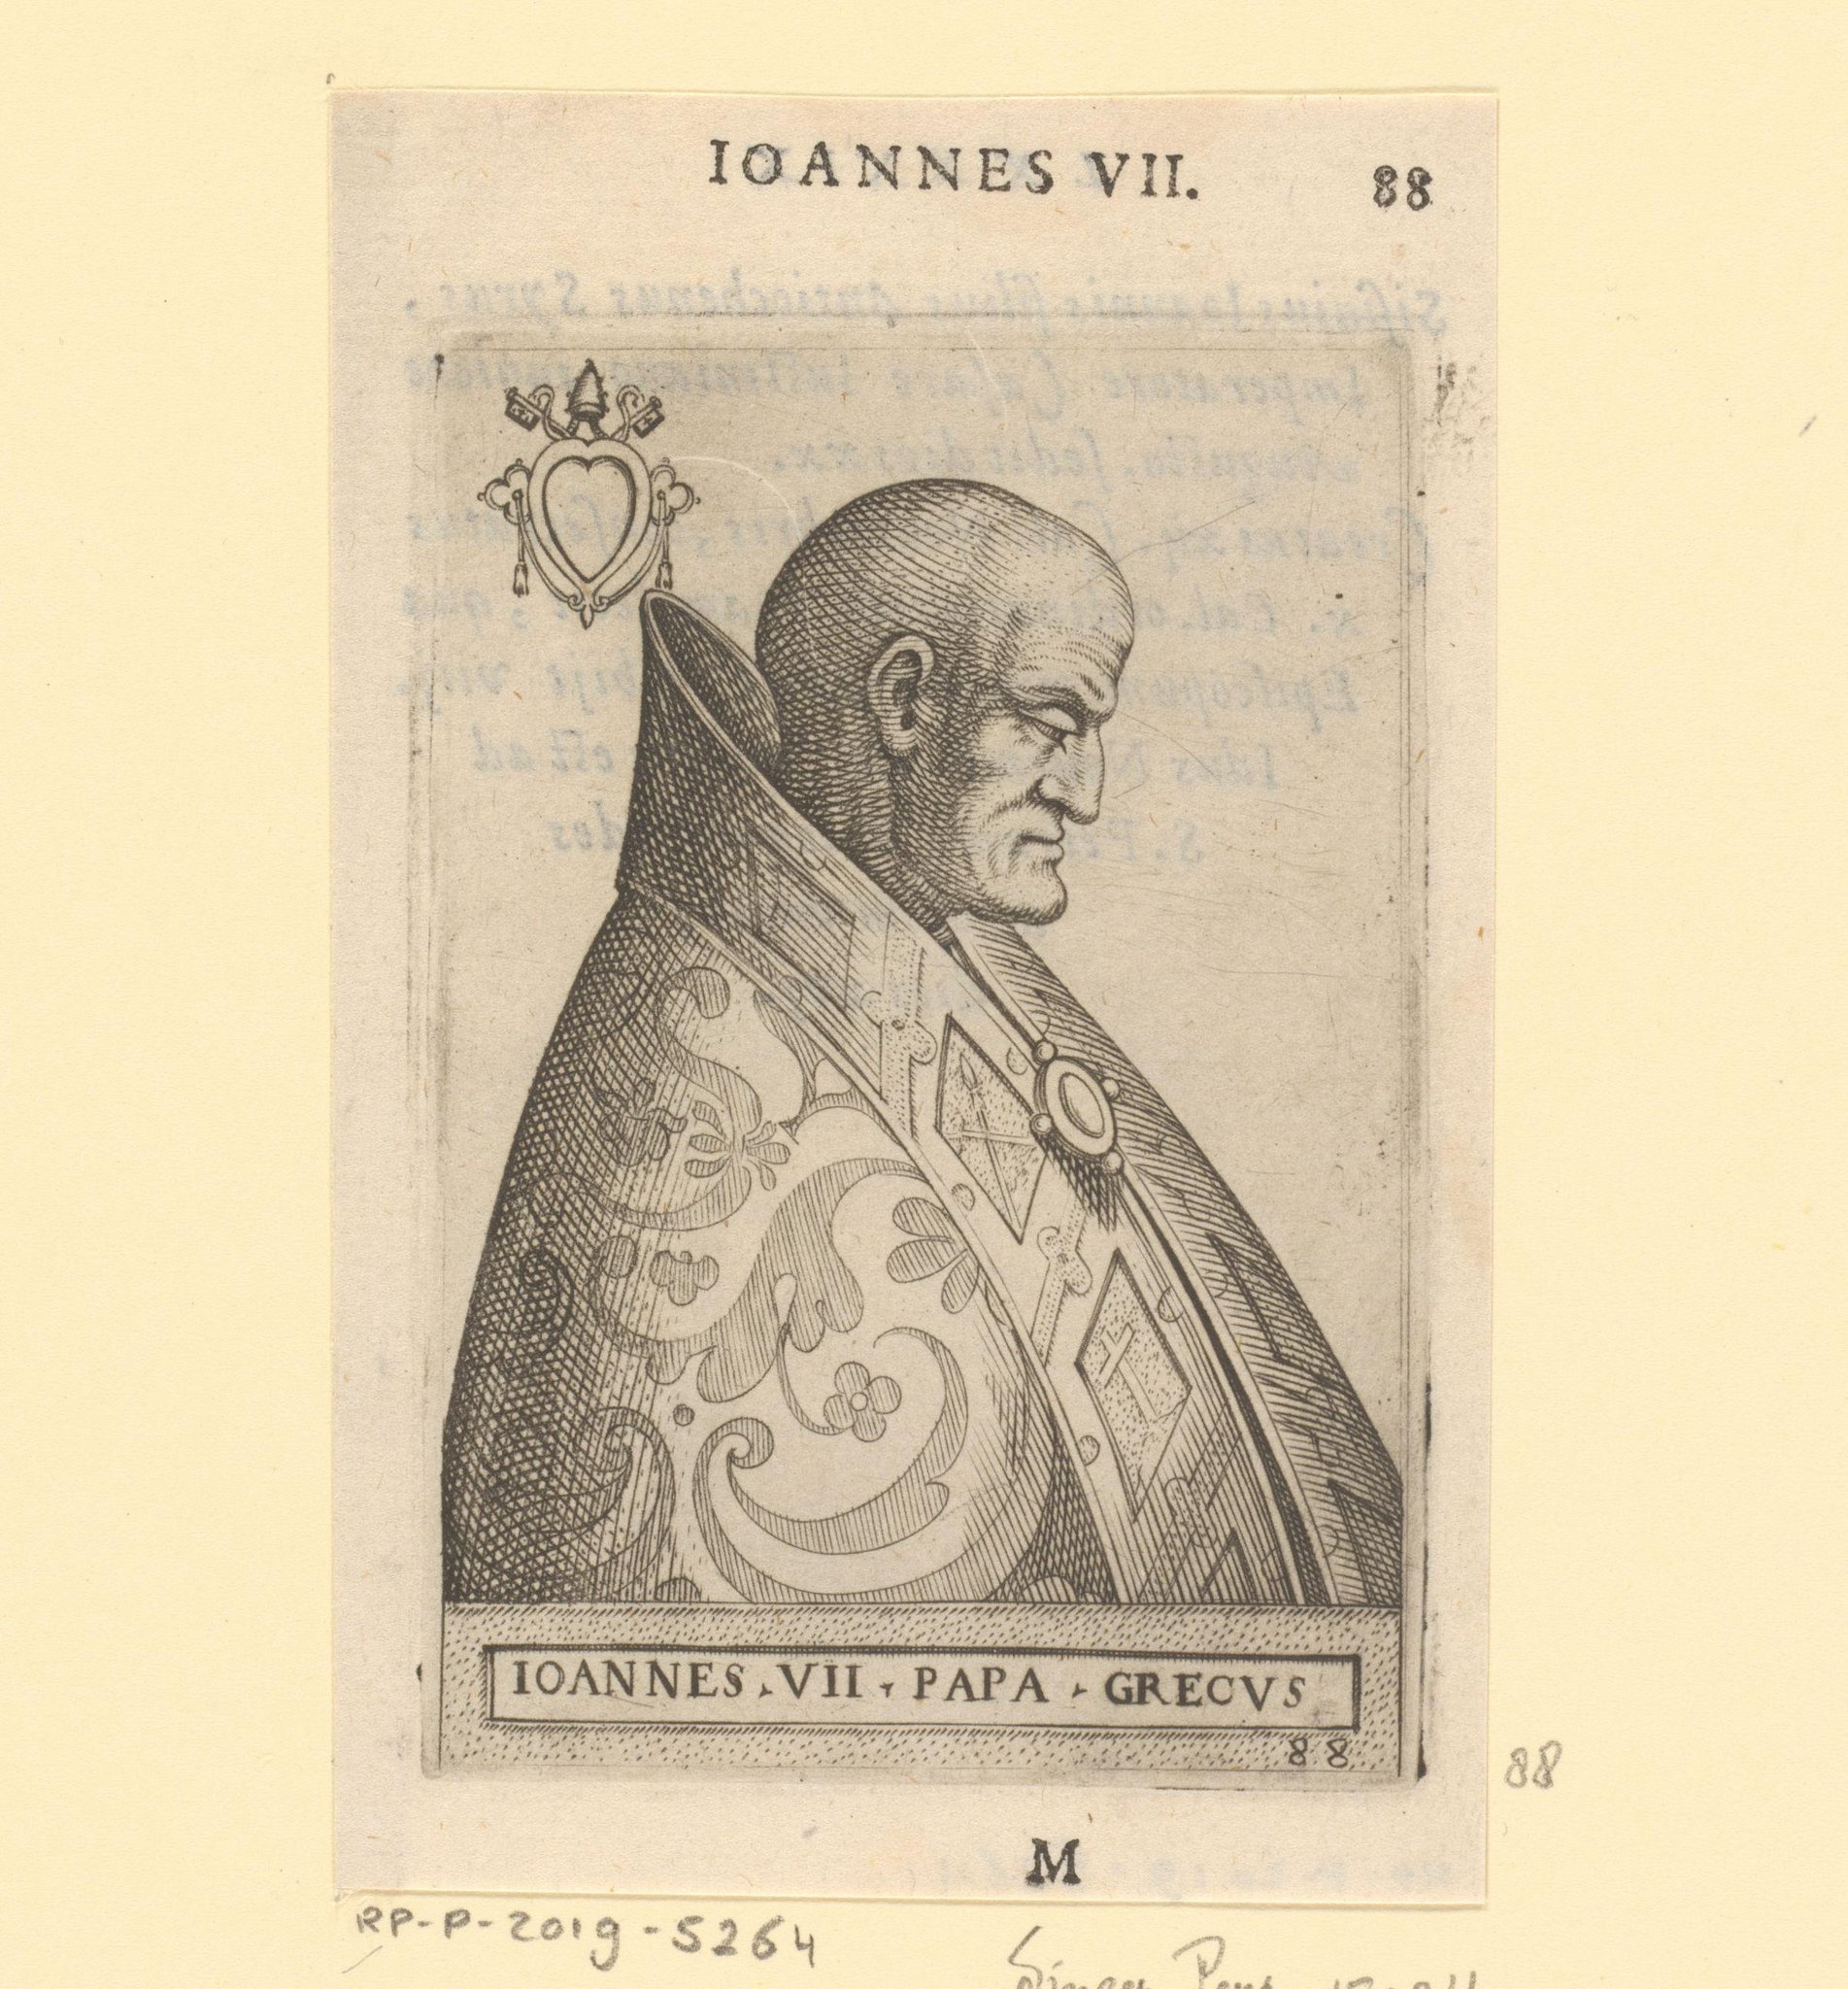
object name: print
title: Portret van paus Johannes VII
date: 1595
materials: paper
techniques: engraving, letterpress printing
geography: rome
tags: historical persons, pope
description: Prent uit: Cavalieri, Giovanni Battista de'. Effigies pontificum romanorum cum eorum vitis (...). Rome: Bartolomeo Bonfadino, 1595. Prent voor het eerst verschenen in: Cavalieri, Giovanni Battista de'. Pontificum romanorum effigies (...). Rome: Domenico Basa en Francesco Zanetti, 1580. Prent ook gebruikt in latere publicaties.